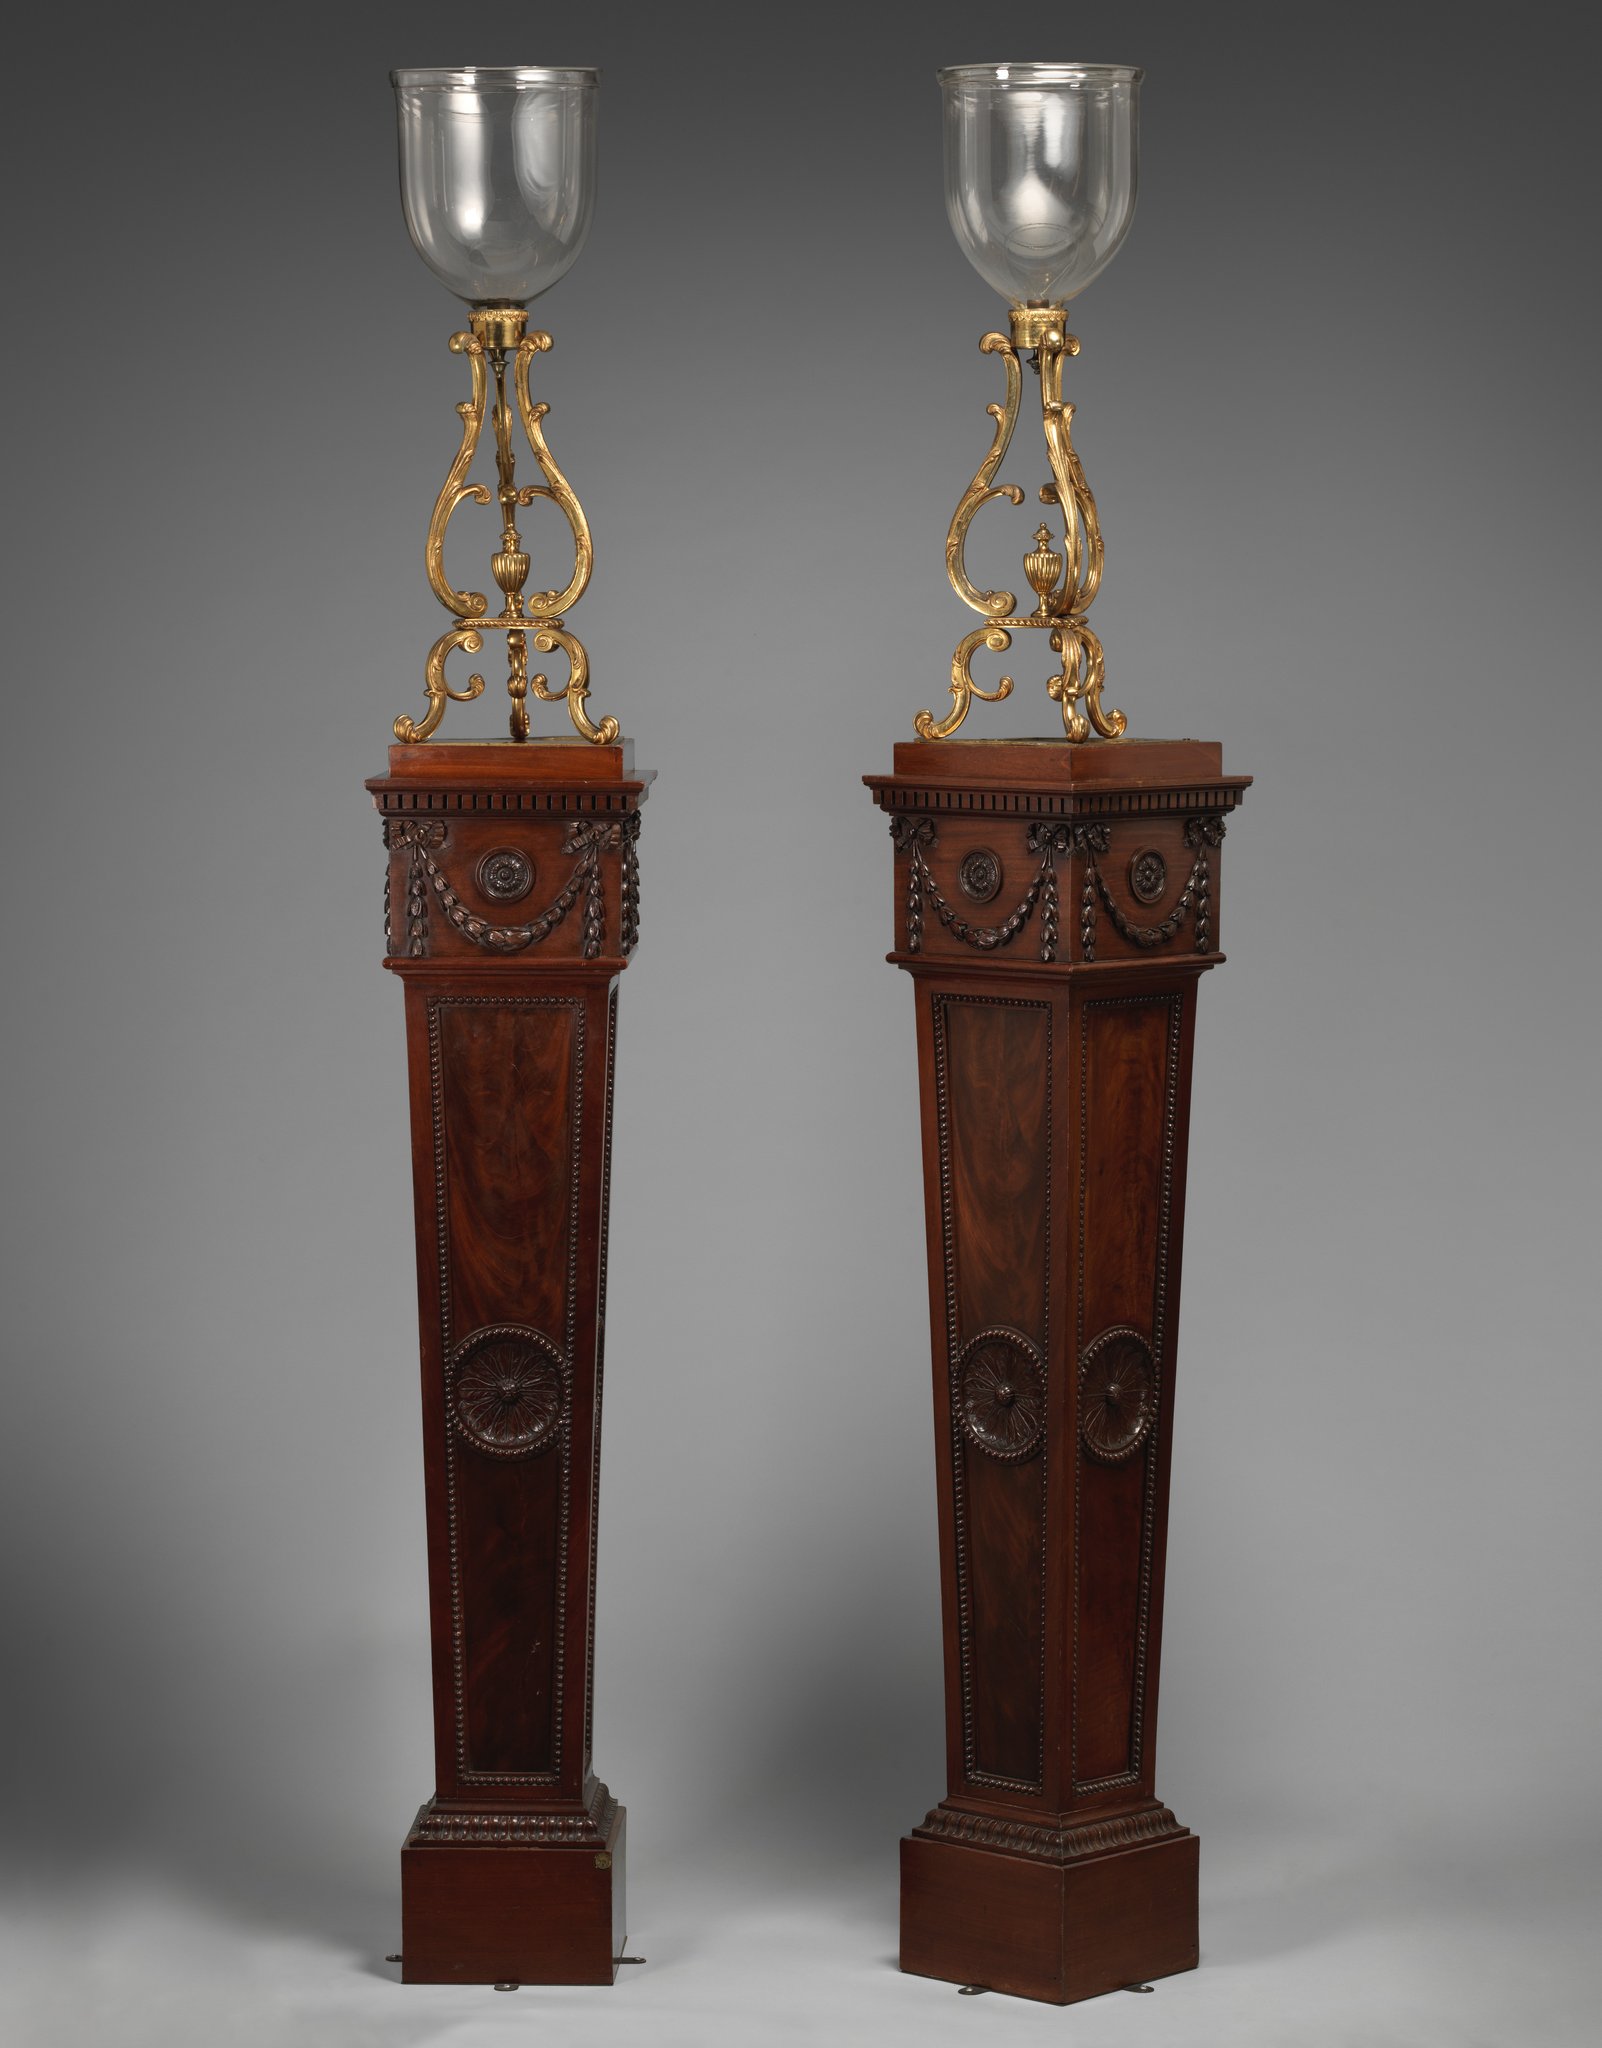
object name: pedestal with candleholder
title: Pedestal with candleholder (one of a pair)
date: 1775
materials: brass, glass, wood